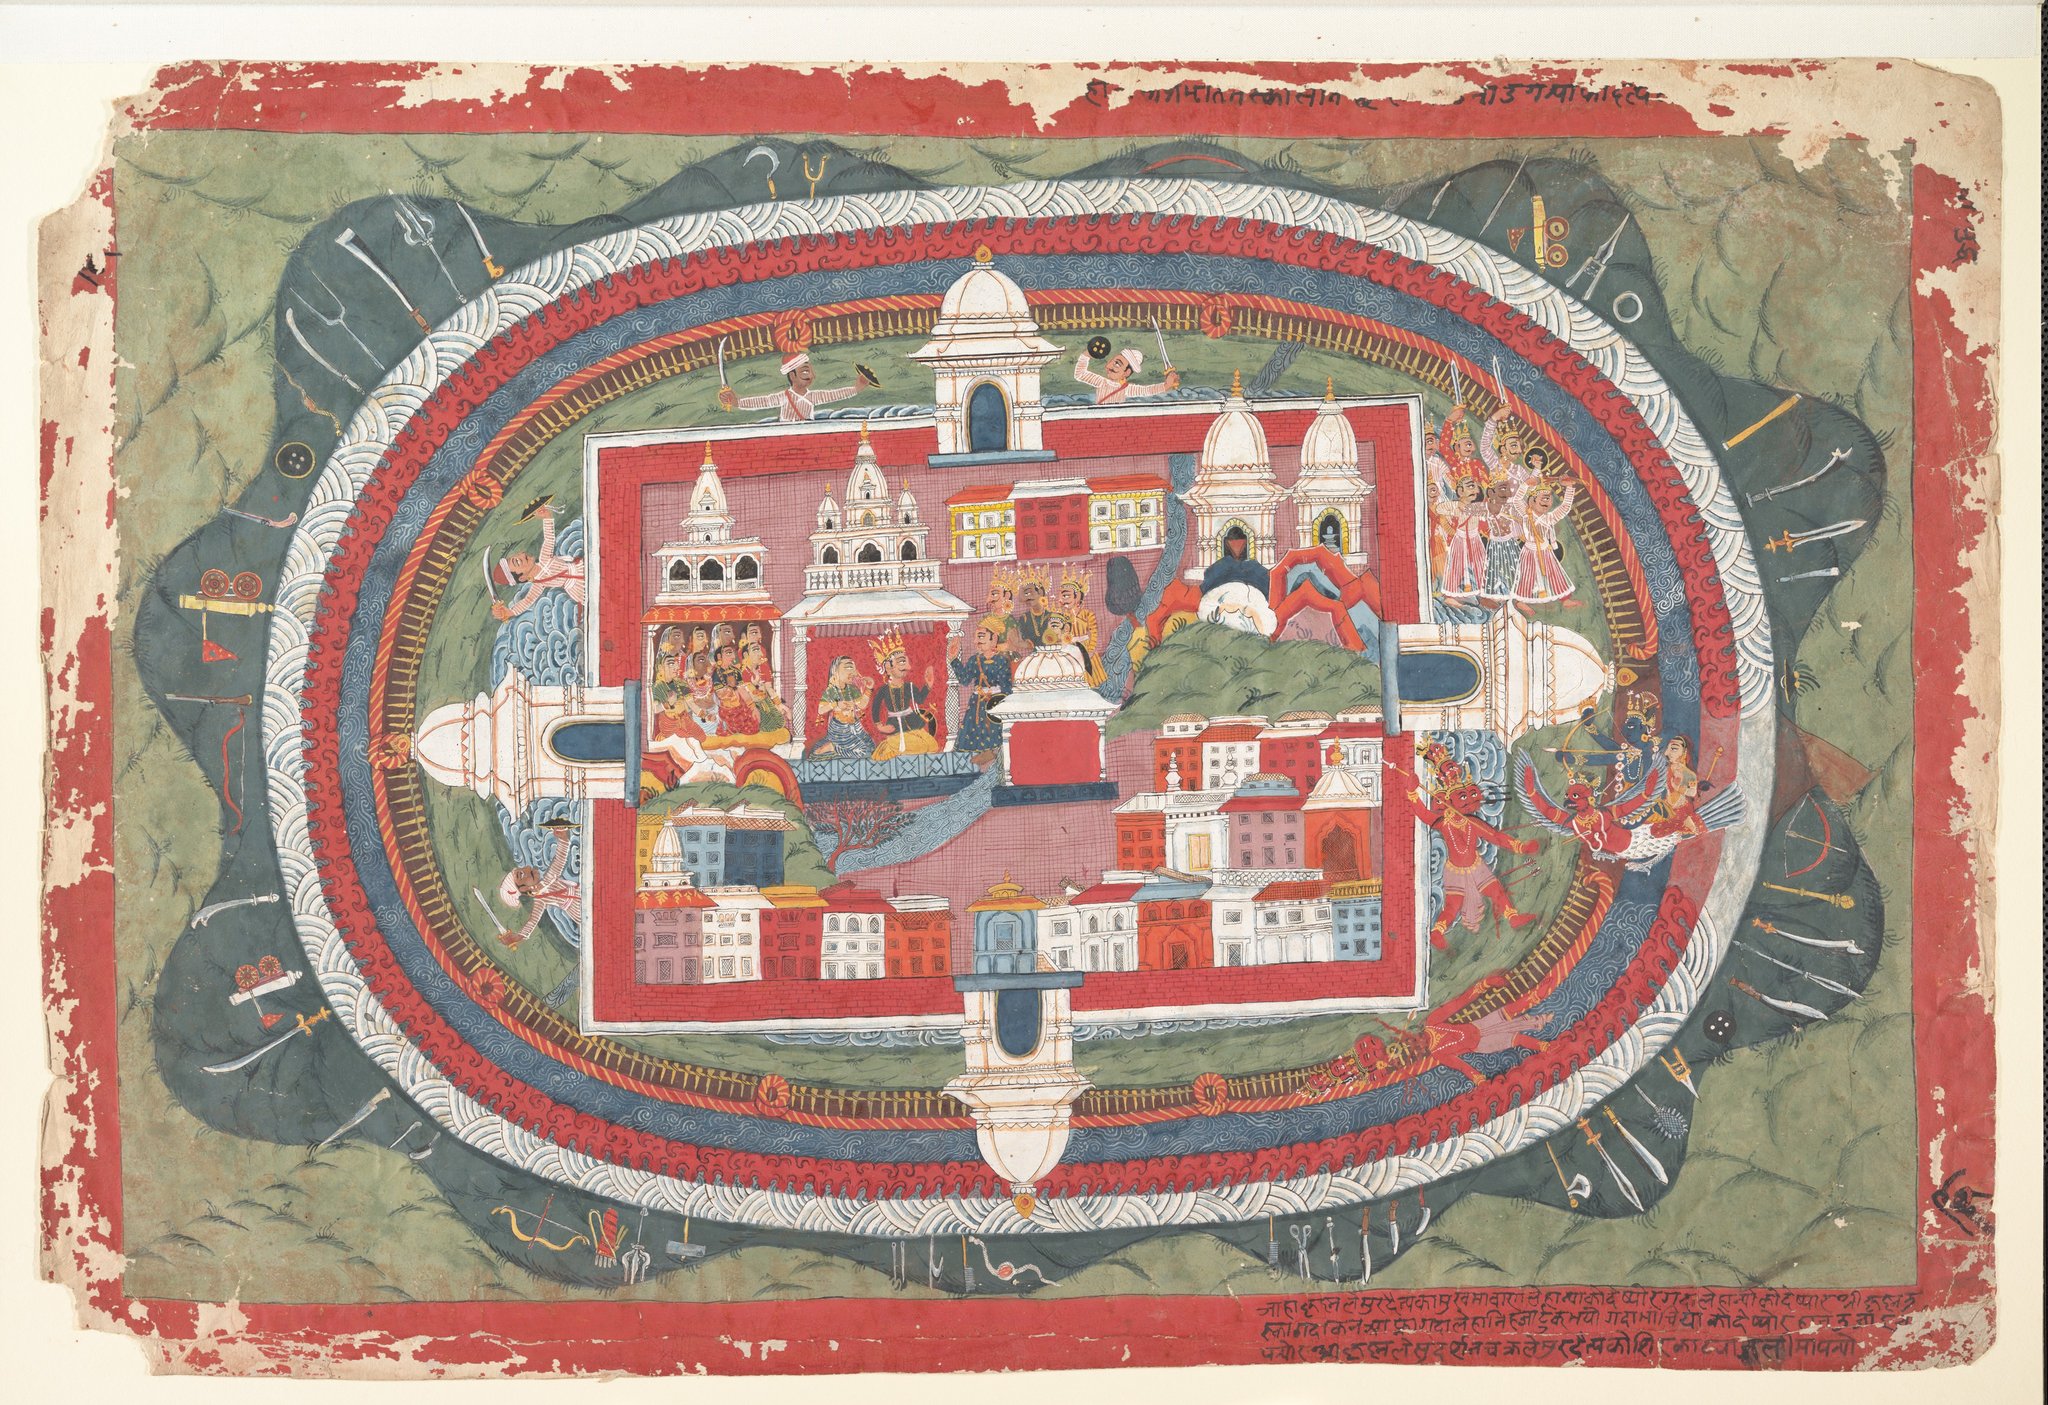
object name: folio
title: Page from a Dispersed Bhagavata Purana Manuscript (Life of Krishna)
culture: nepali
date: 1775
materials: paper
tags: castles,demons,krishna